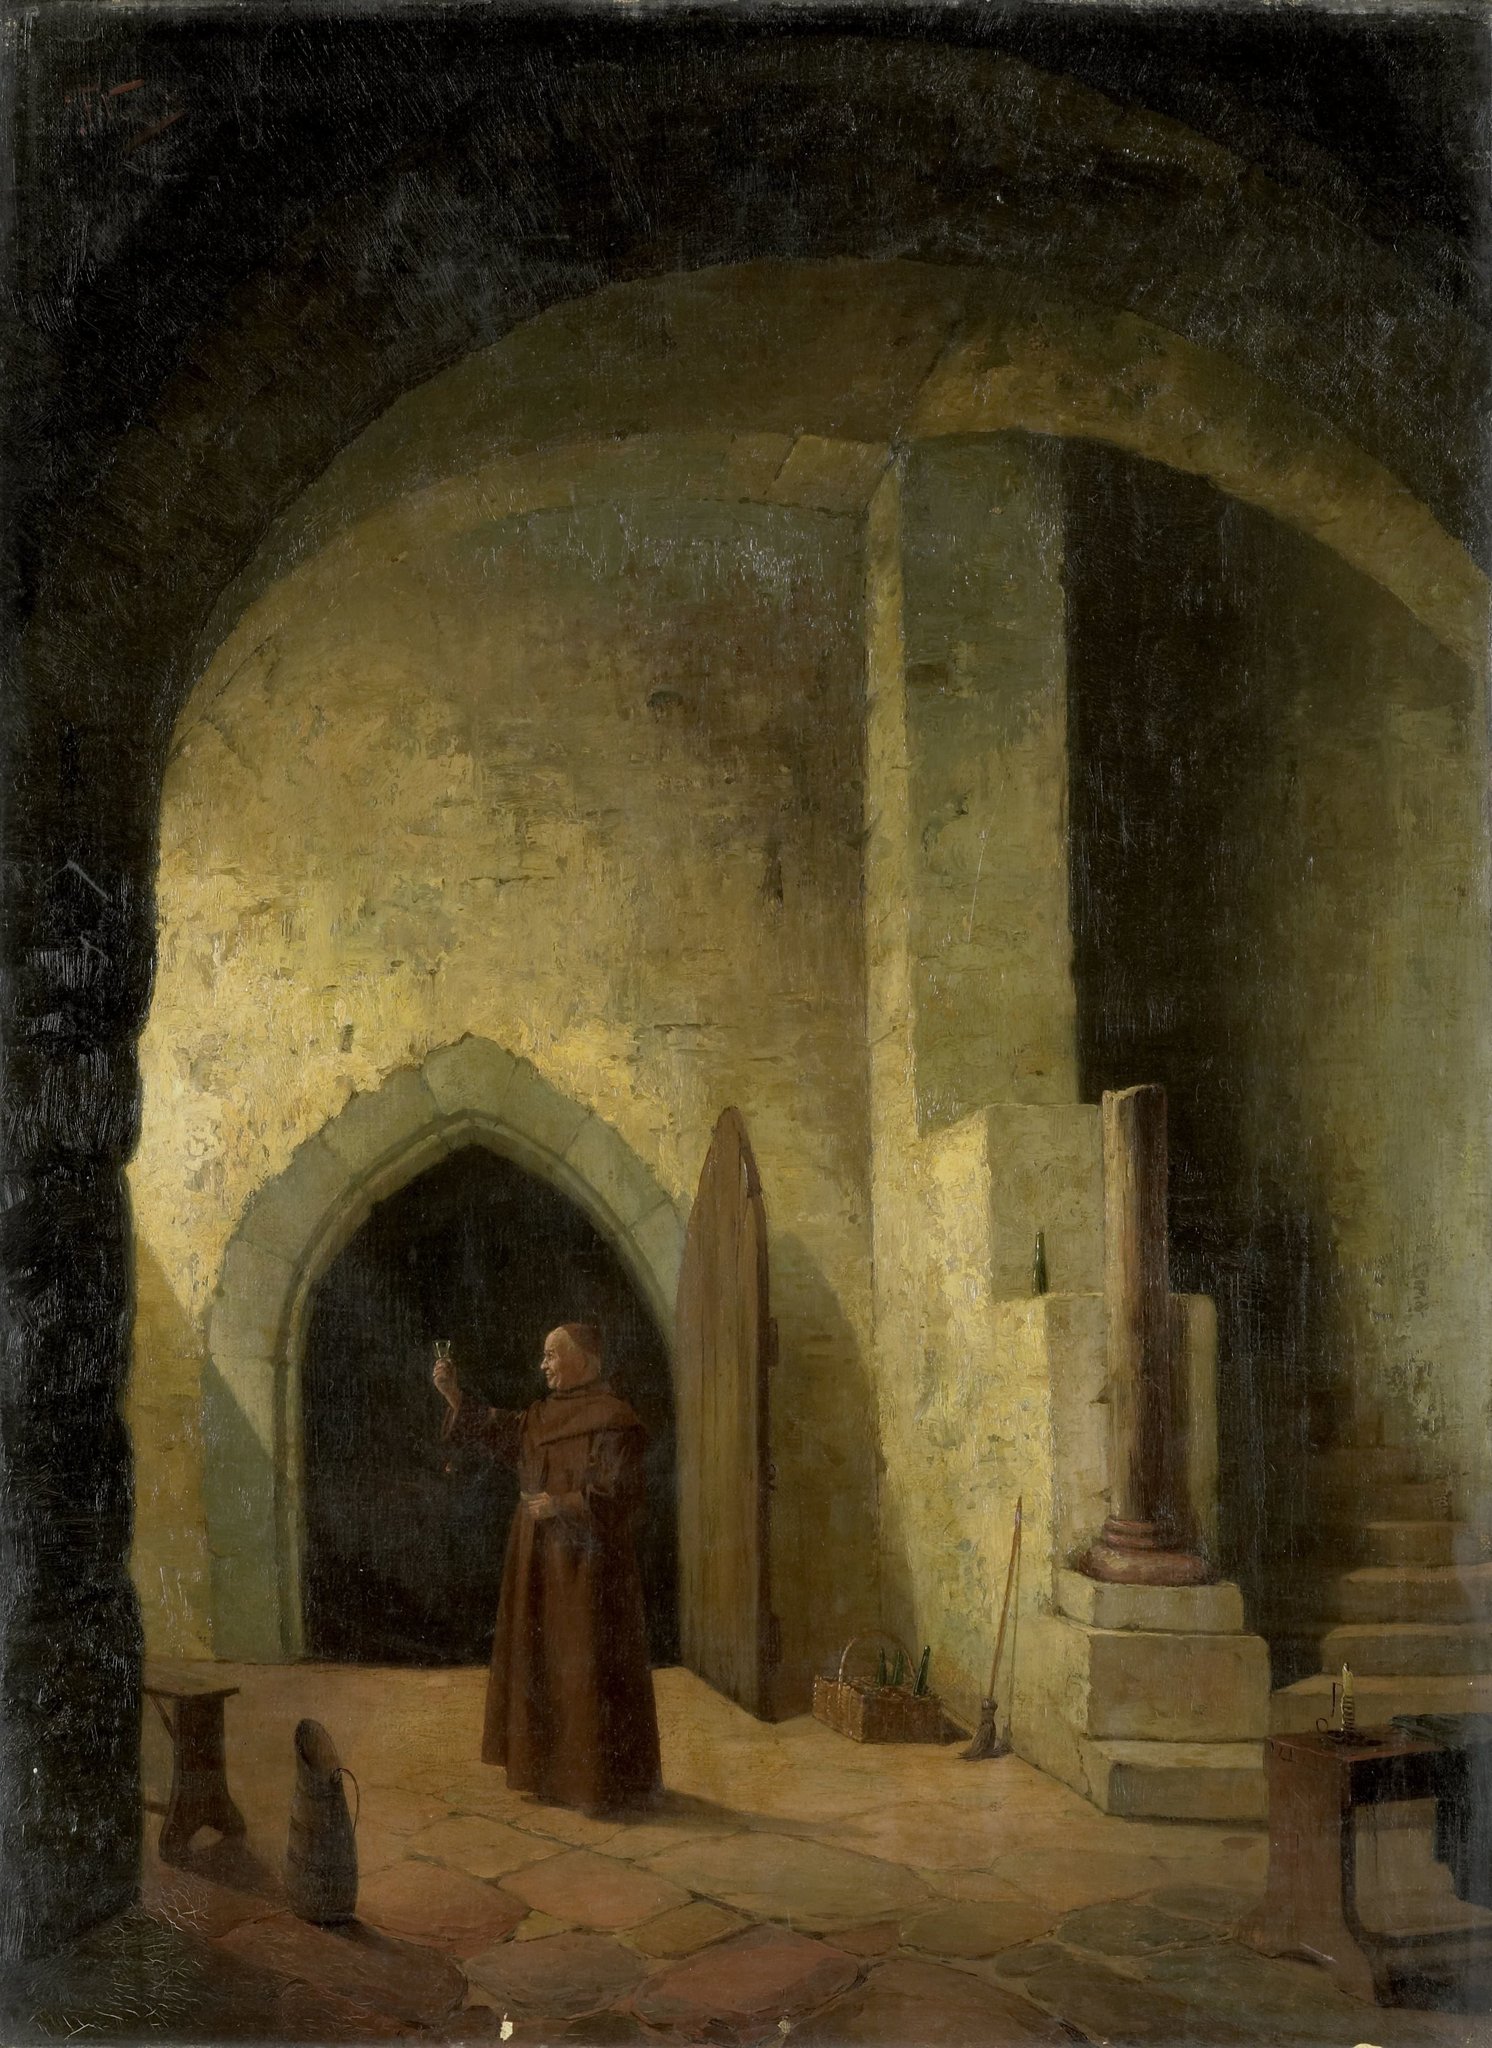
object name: painting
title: Een monnik met een glas in de hand in een kelder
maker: f. taupel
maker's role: painter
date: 1800-1900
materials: canvas, oil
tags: monk(s), friar(s)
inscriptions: signature: ‘F. Taupel’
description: In een kelder houdt een monnik een glas met wijn in de hand tegen het licht.